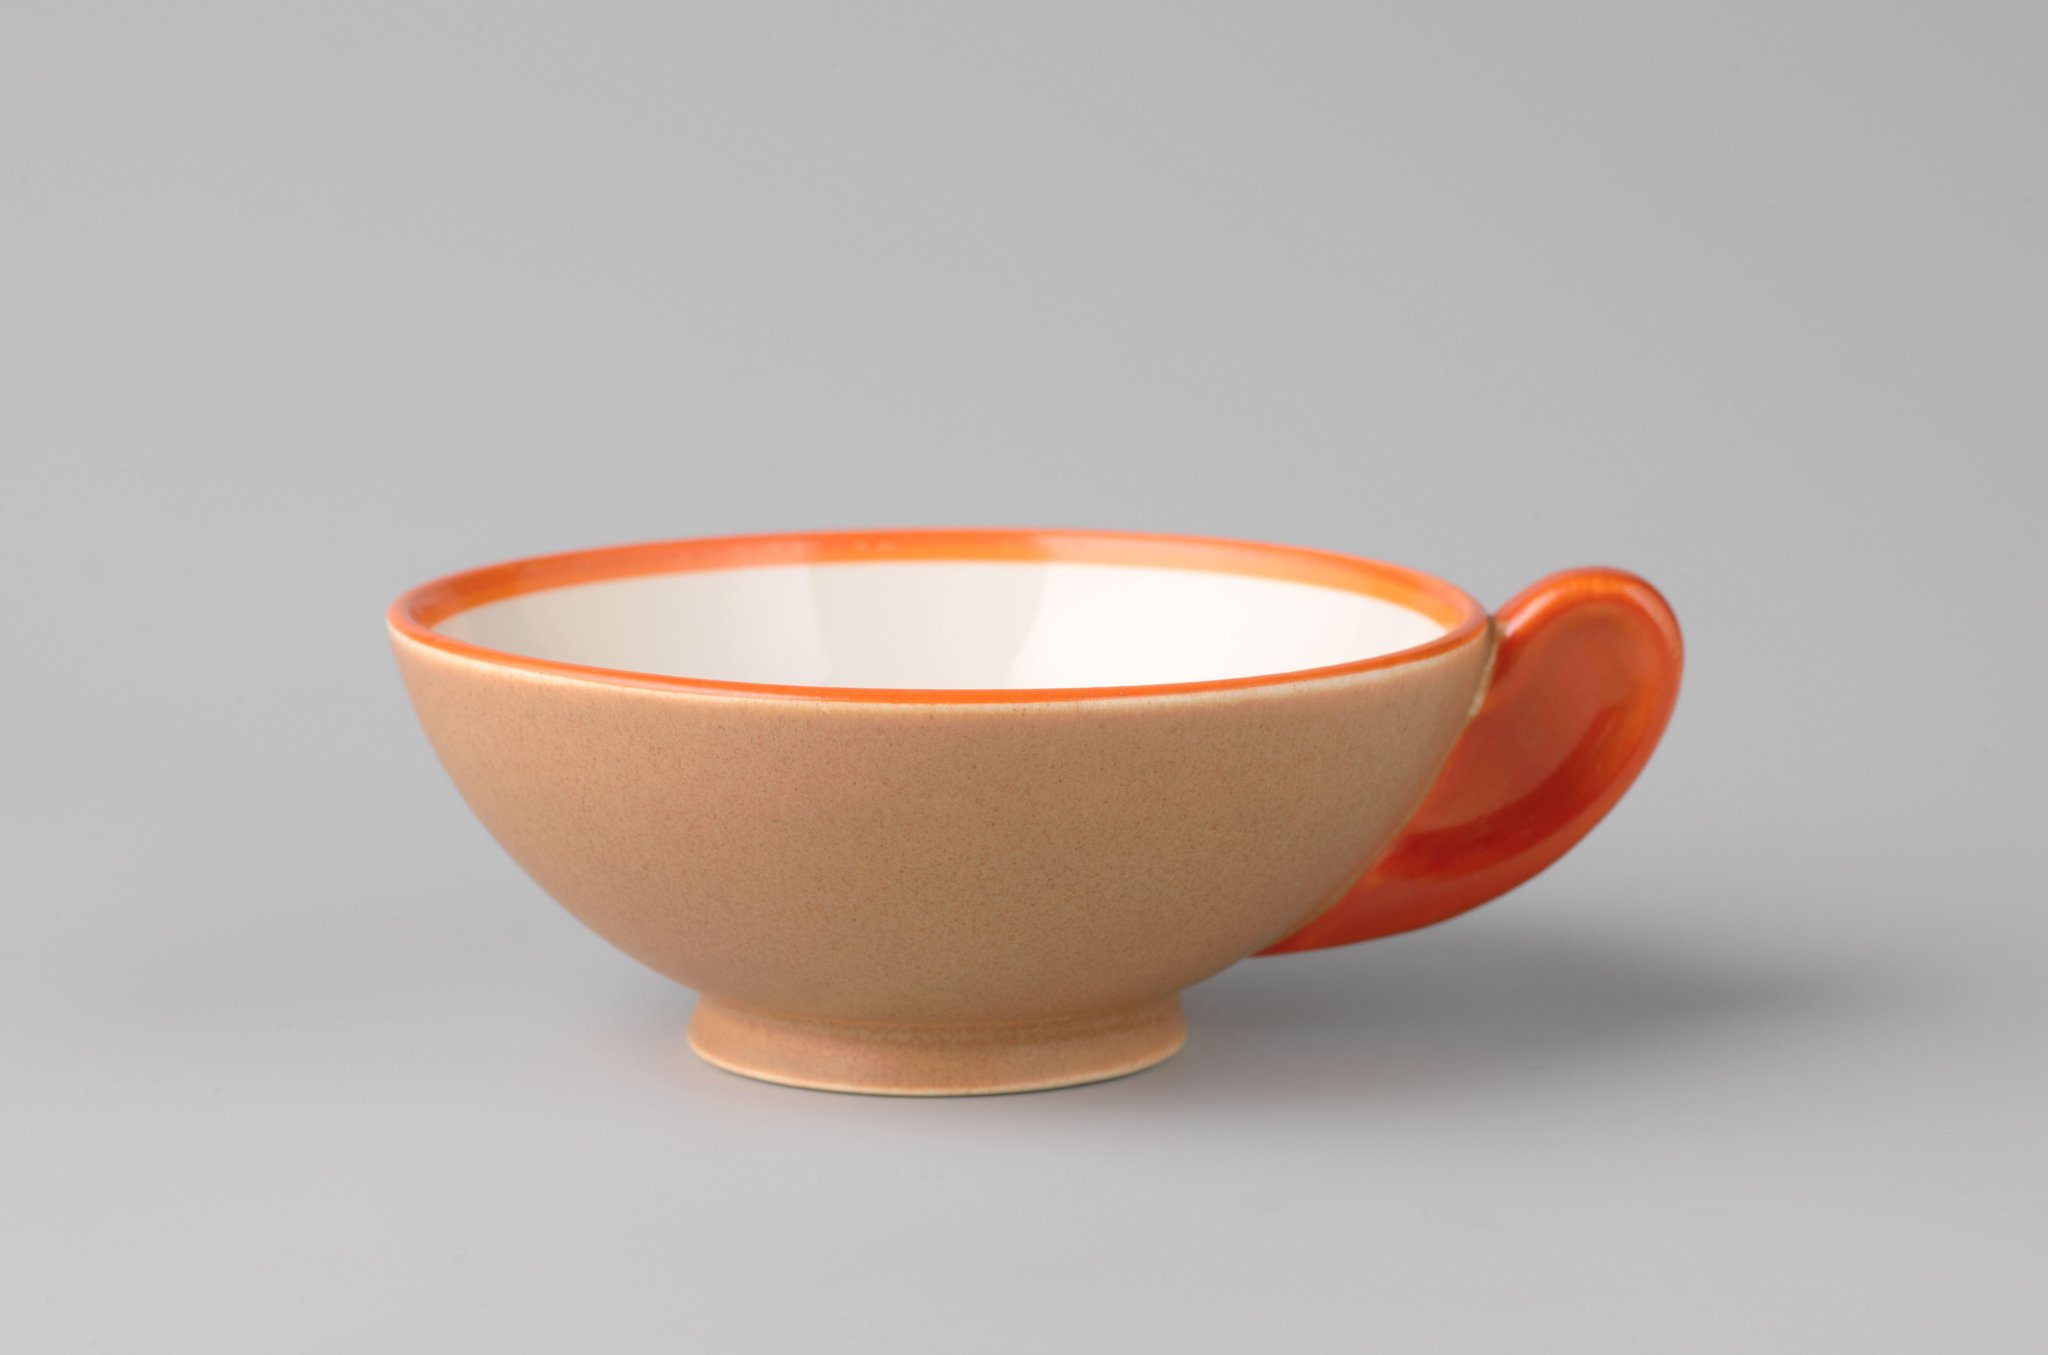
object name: tea cup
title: Theekop, deel van een theeservies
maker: edmond bellefroid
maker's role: ceramicist, painter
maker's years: 1893-1971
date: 1934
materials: earthenware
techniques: painted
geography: maastricht